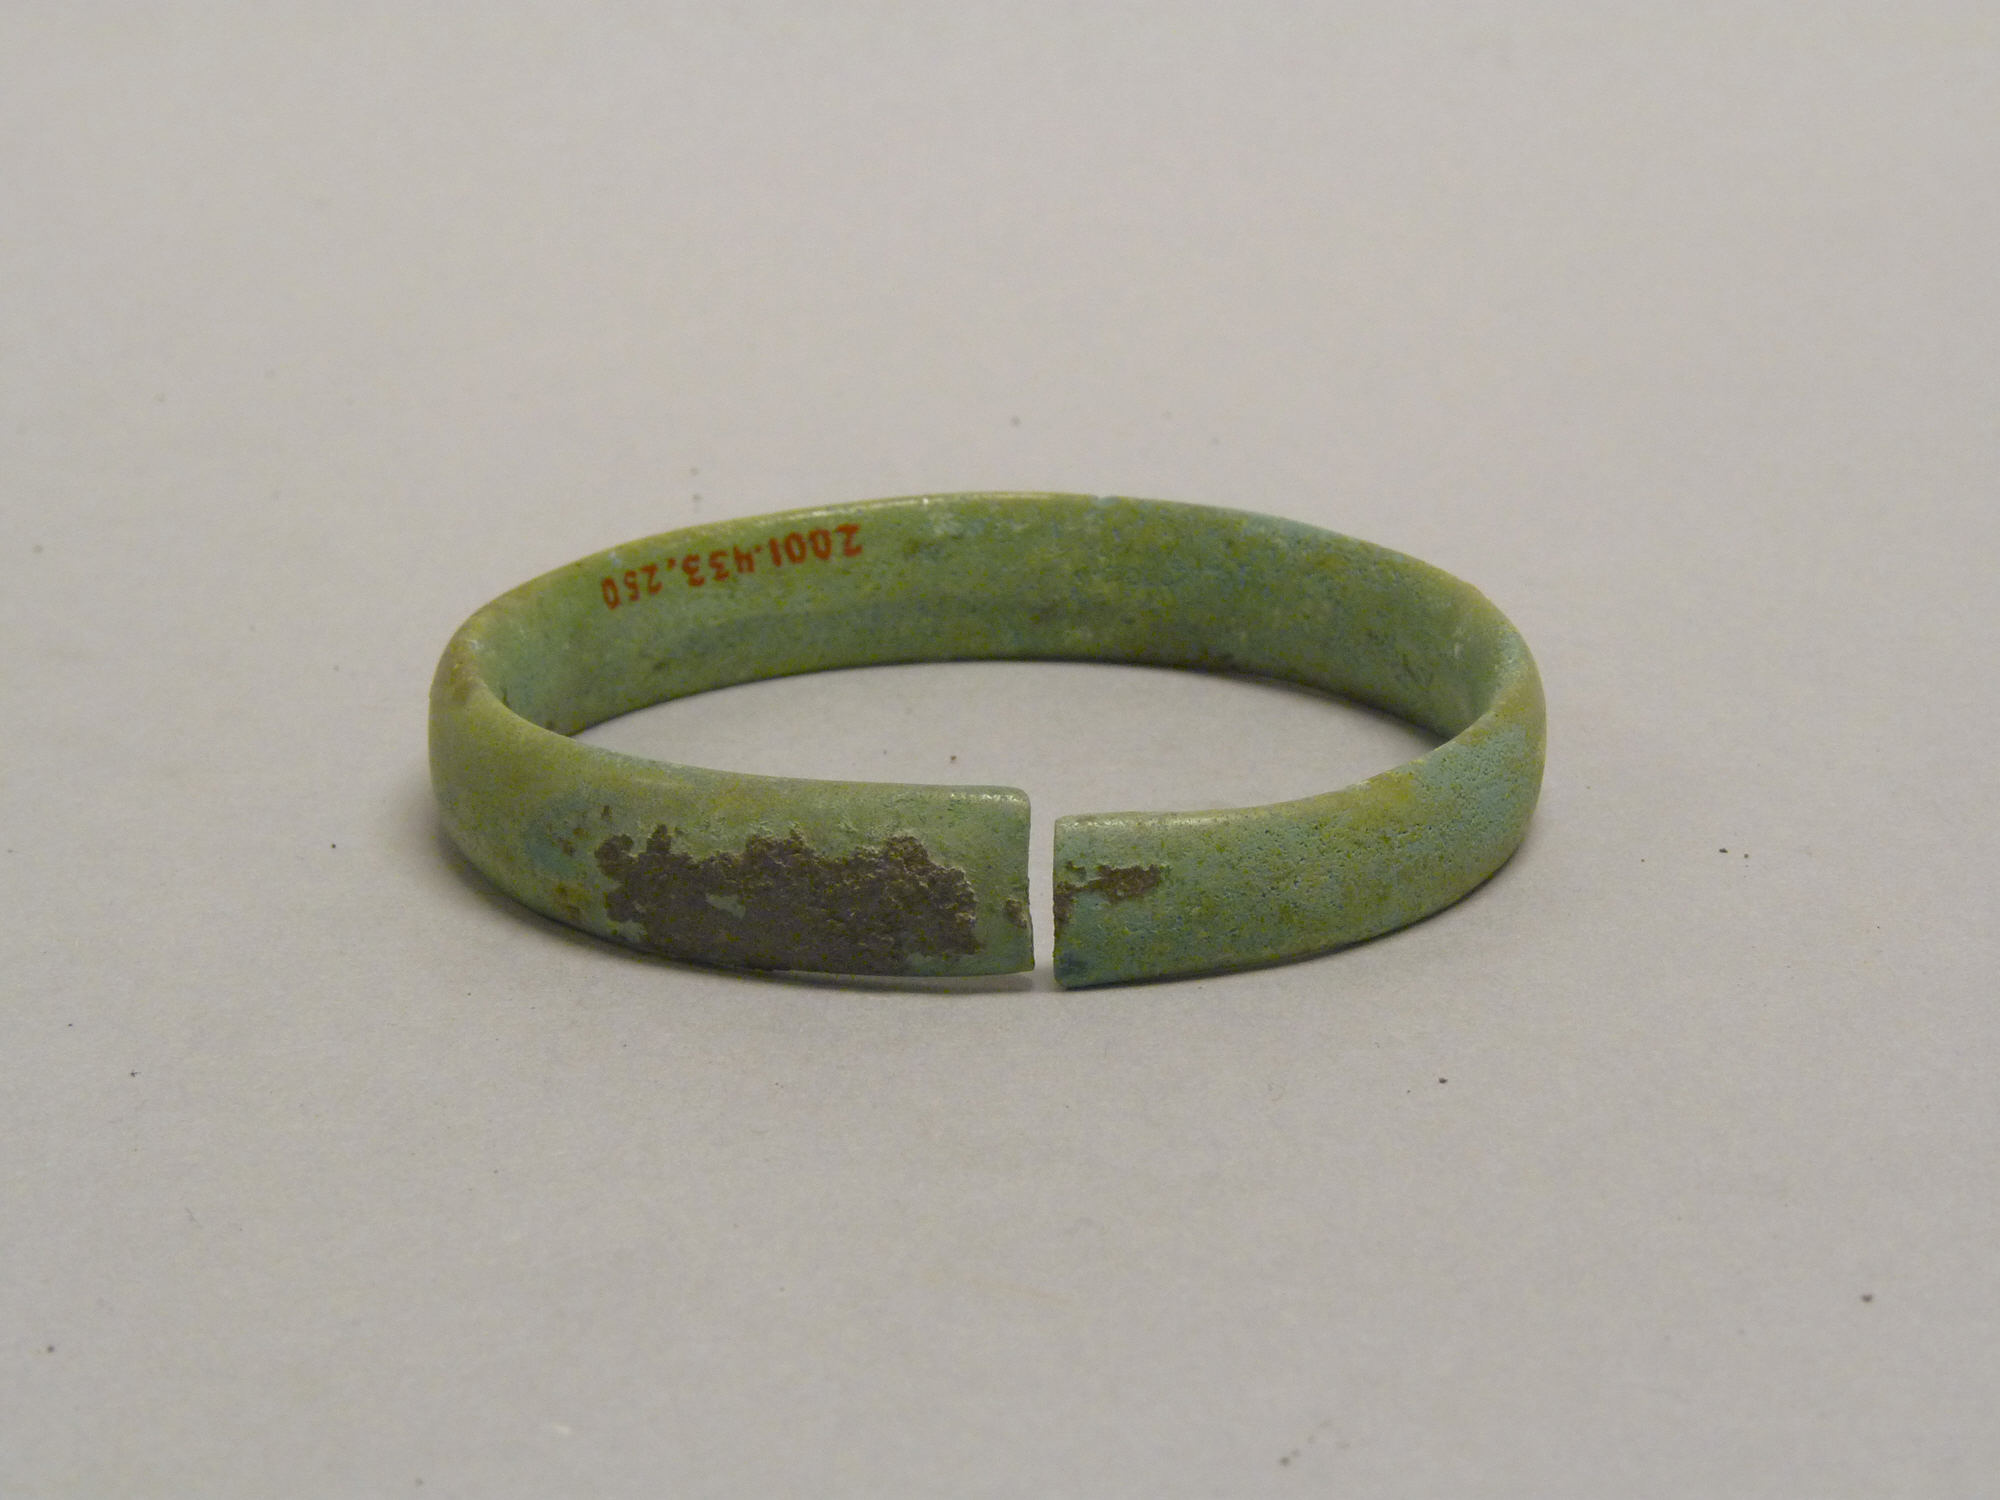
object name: bracelet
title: Undecorated Bracelet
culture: thai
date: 1000 BCE-400 CE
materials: bronze